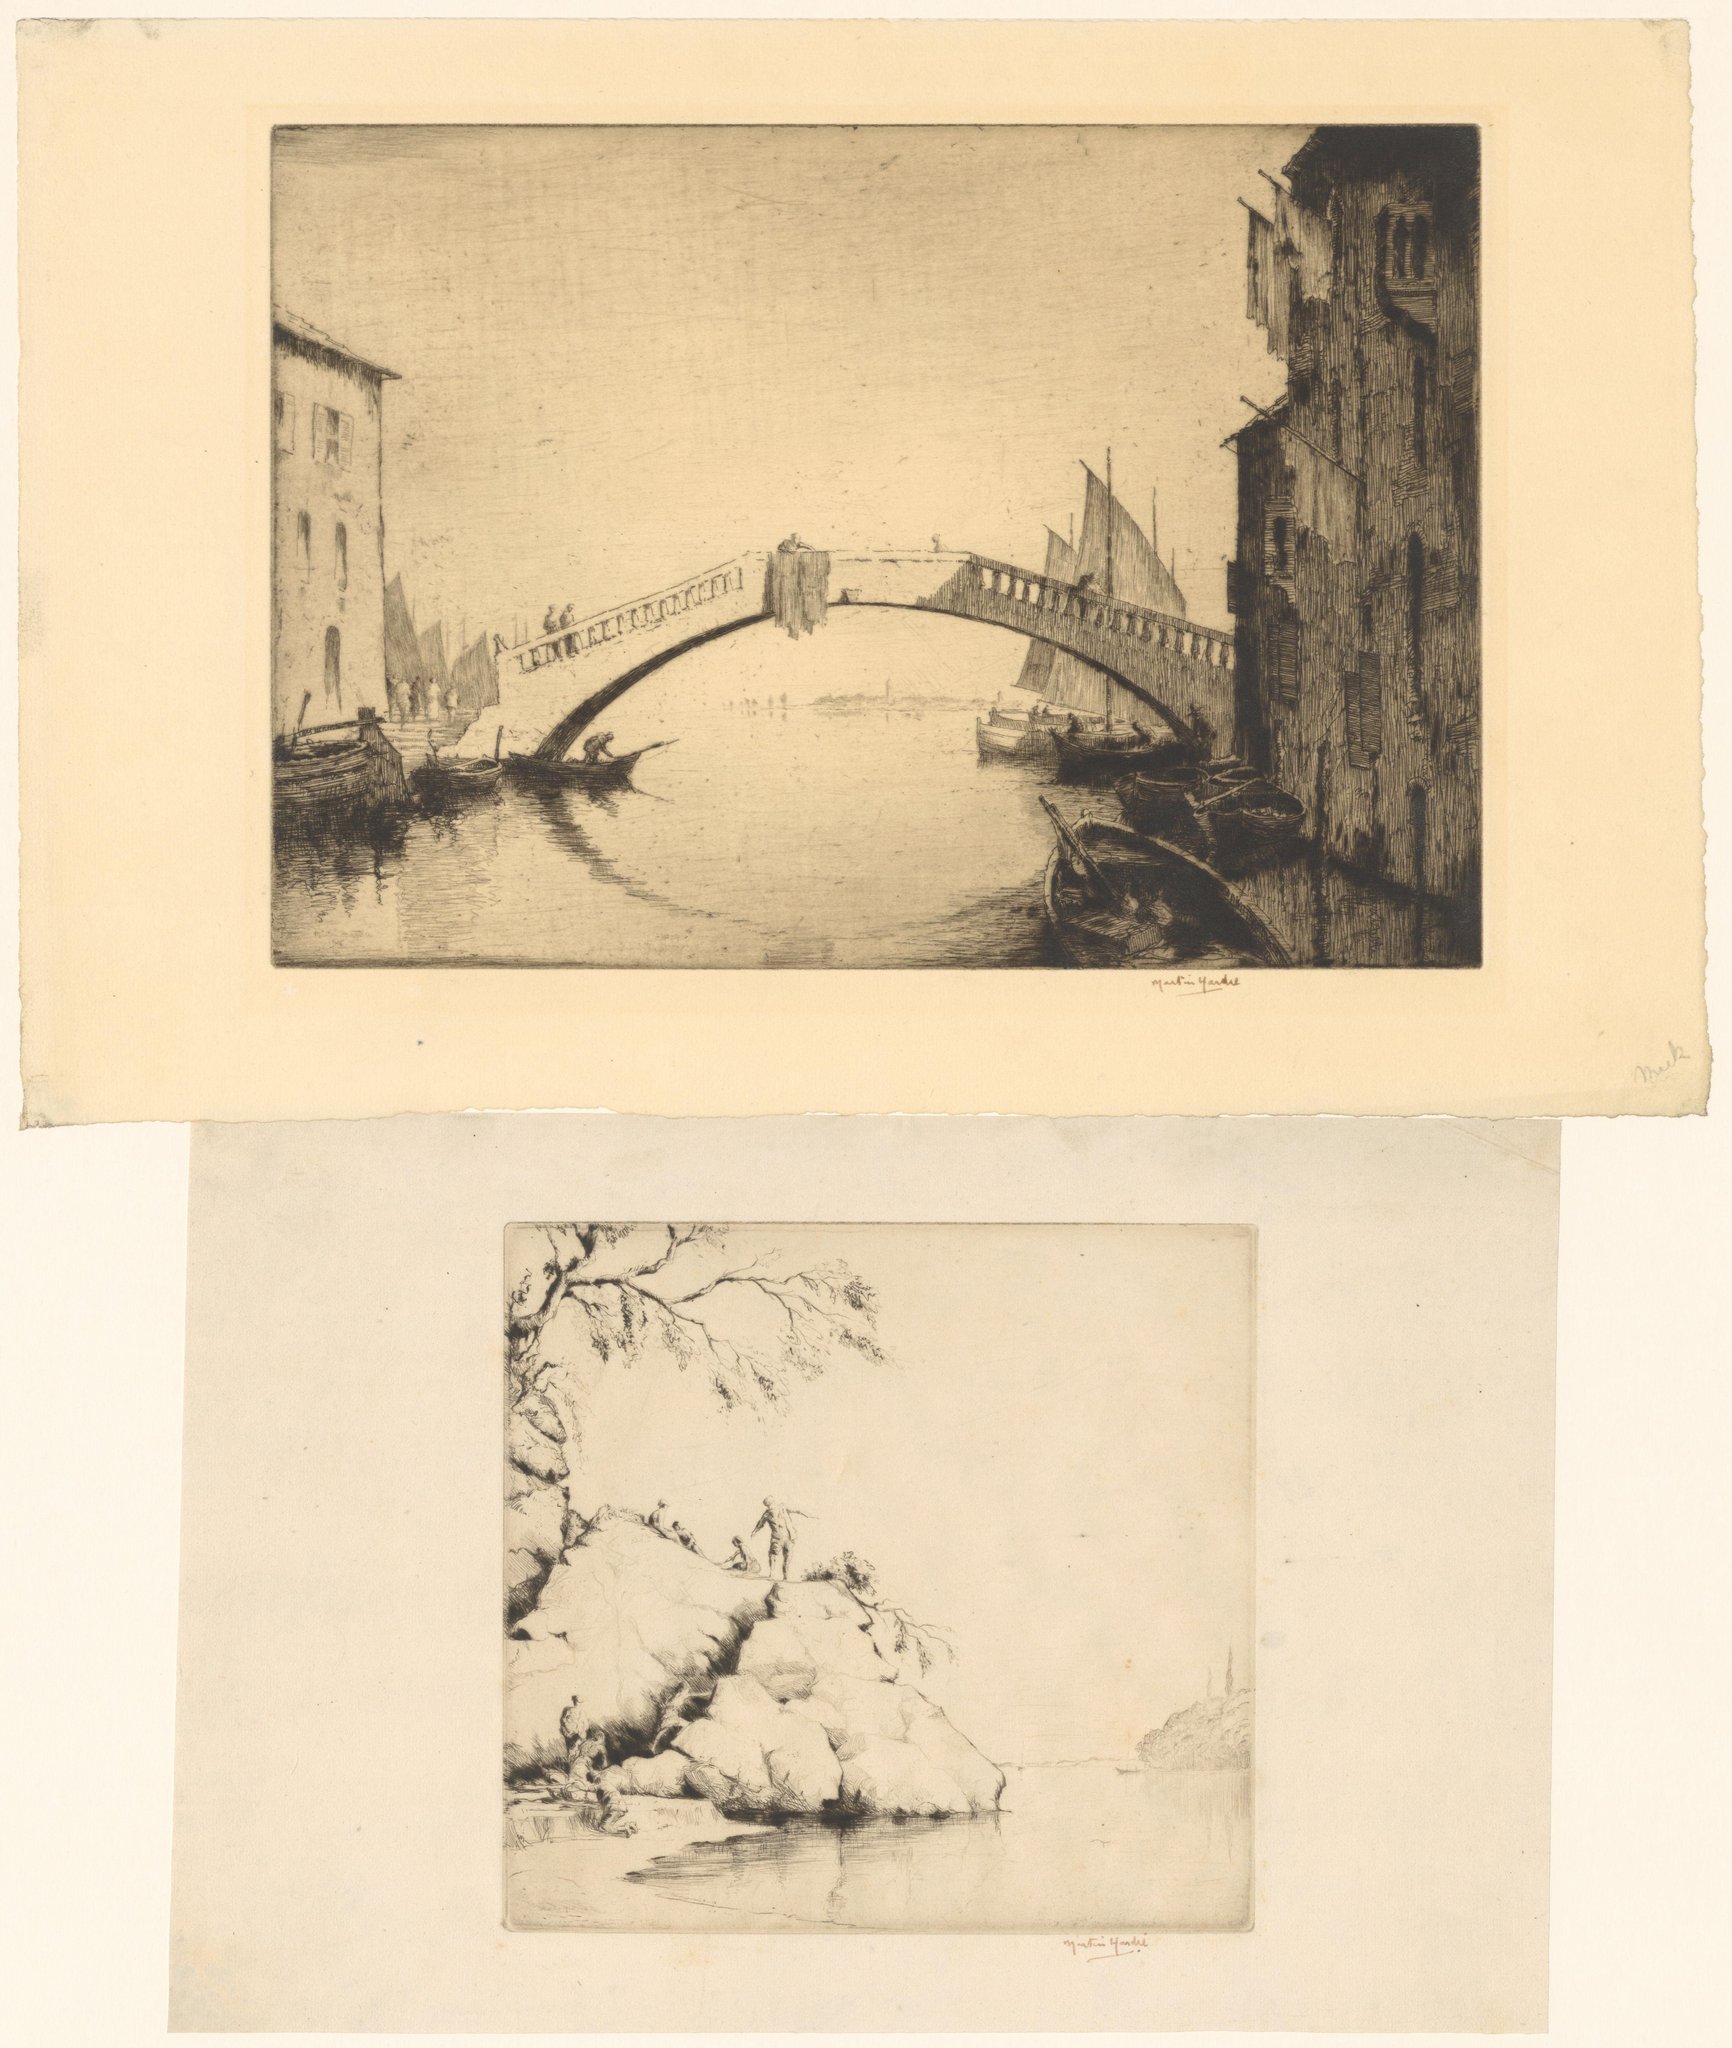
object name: print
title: The Bridge, Chioggia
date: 1926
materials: paper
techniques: drypoint, etching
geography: chioggia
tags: bridge in city across river, canal, etc. (+ city(-scape) with figures, staffage)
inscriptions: collector's mark: Lugt 2760, collector's mark: Lugt 2228, annotation: ‘Martin Hardie’